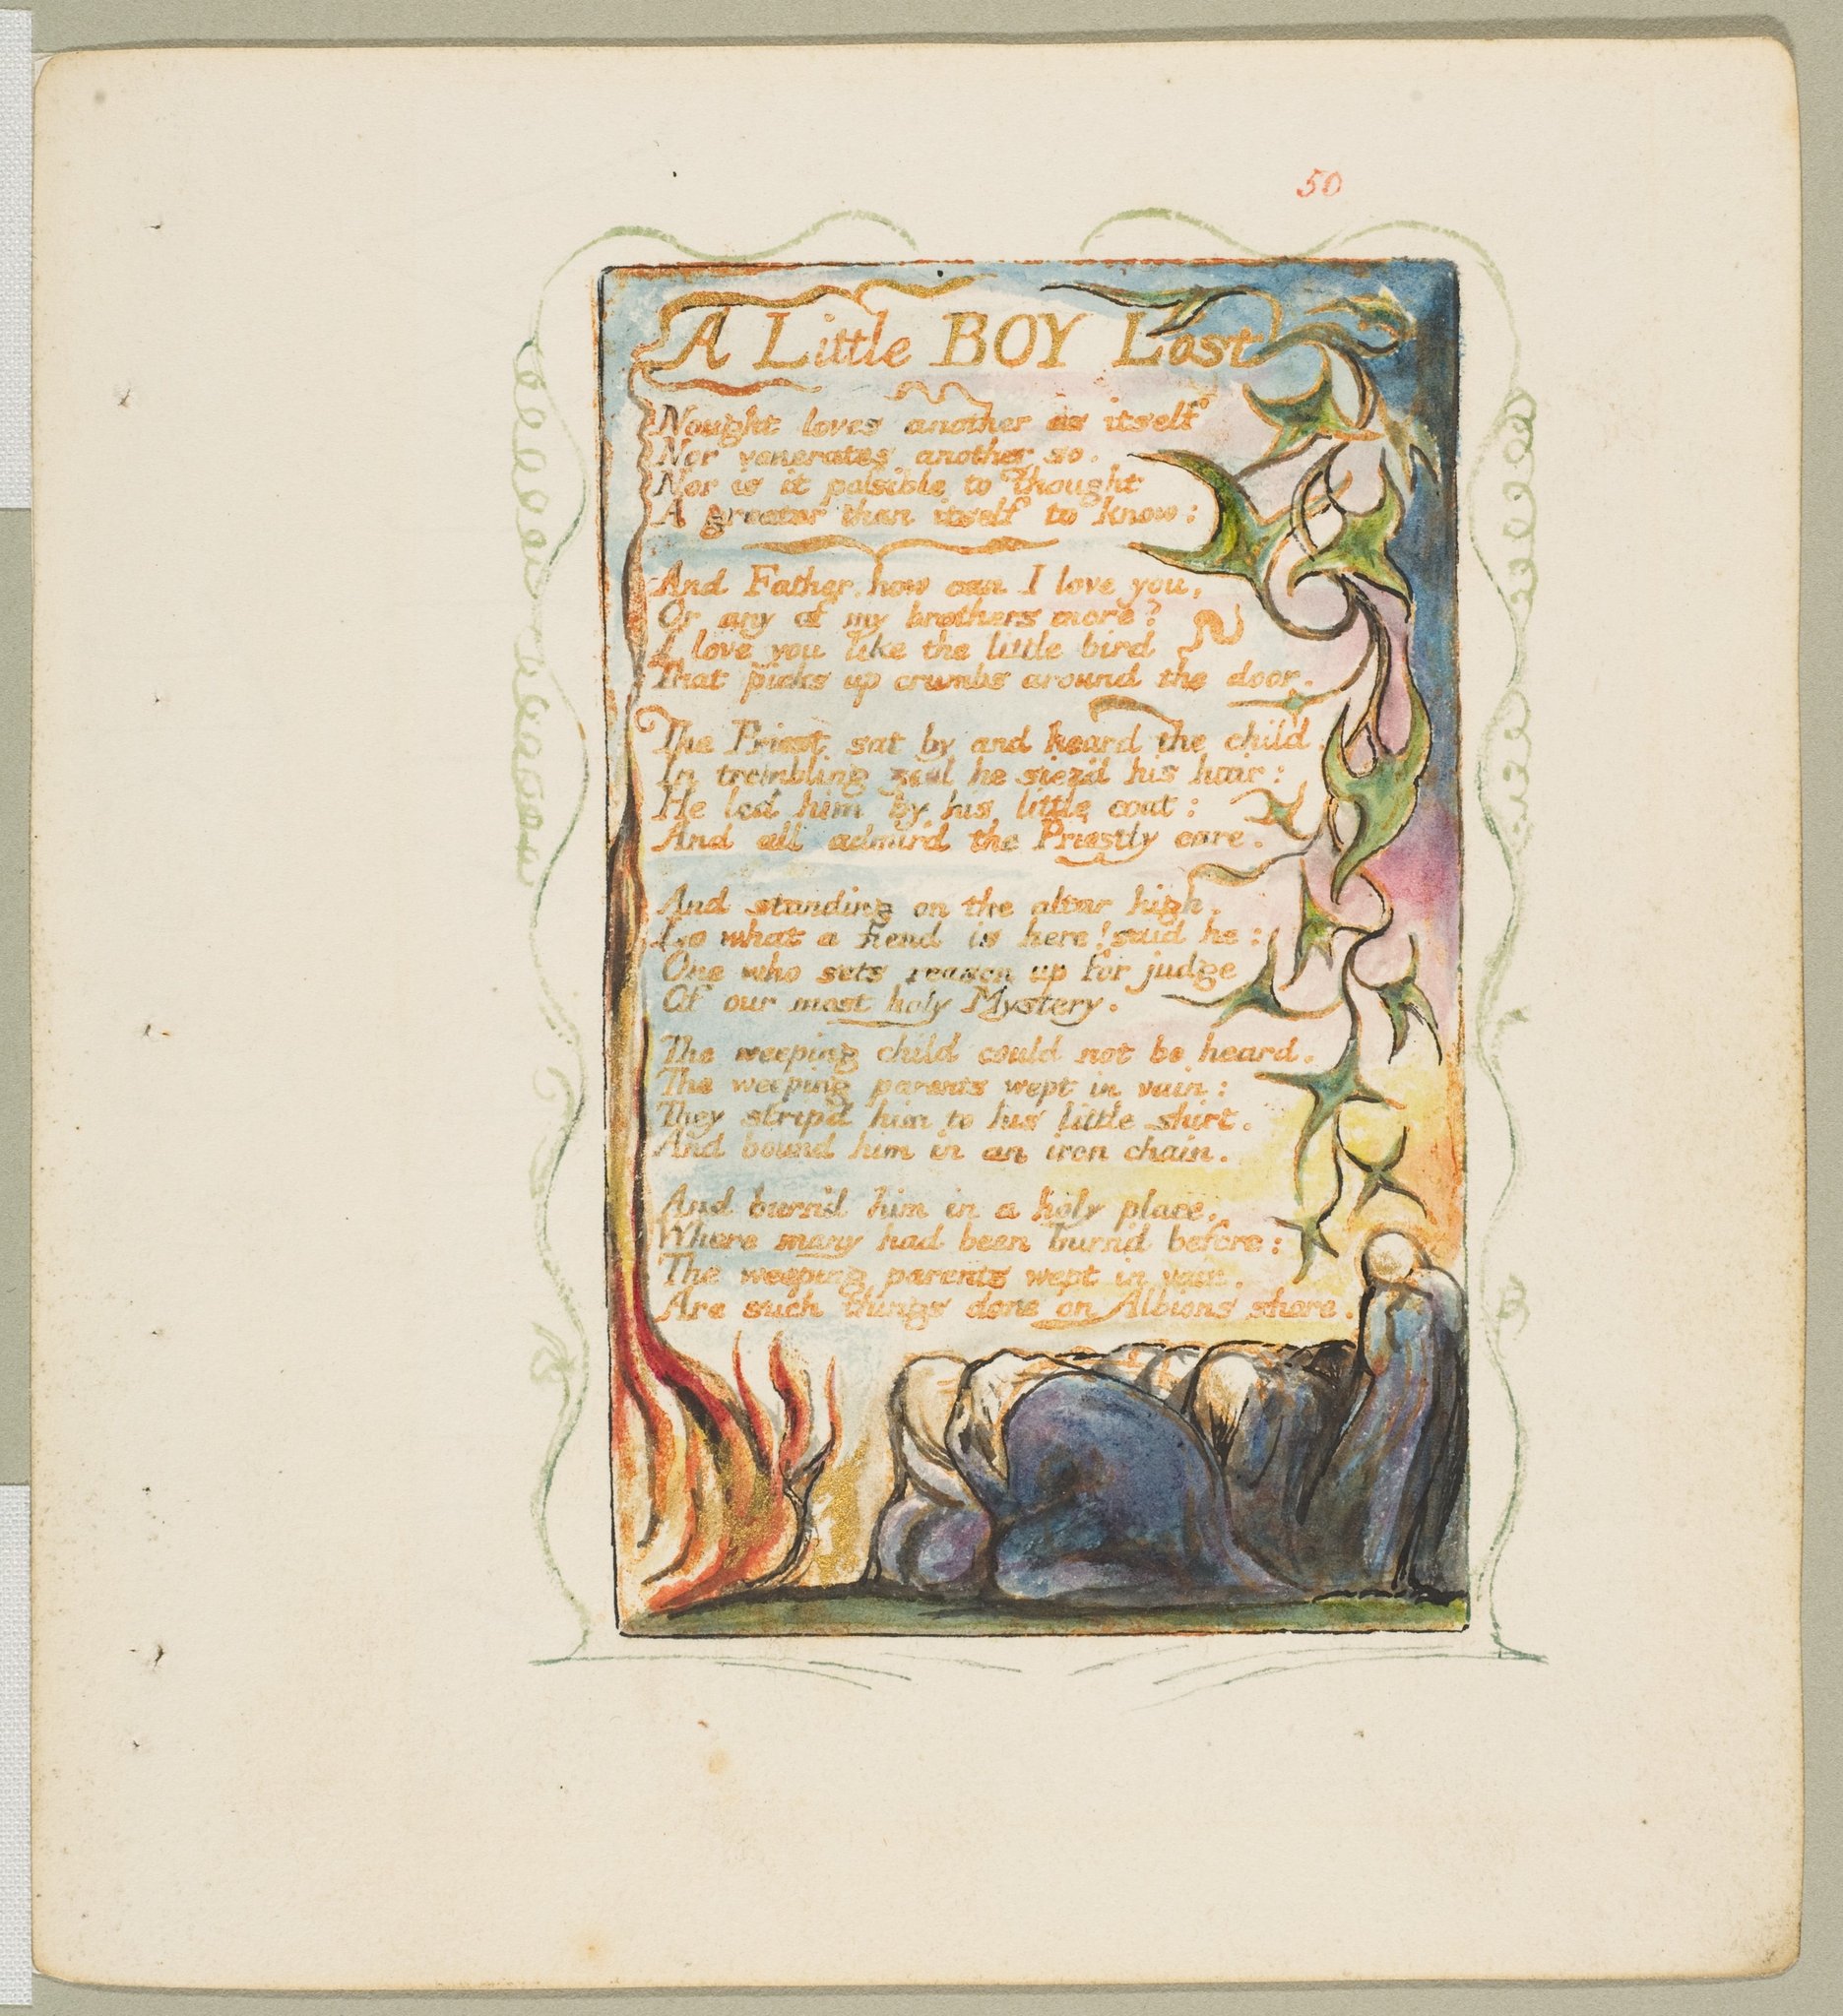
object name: print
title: Songs of Experience: A Little Boy Lost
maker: william blake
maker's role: artist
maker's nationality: british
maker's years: 1757-1827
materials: gold, ink, shell, watercolor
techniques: etching, hand coloring, printing, relief